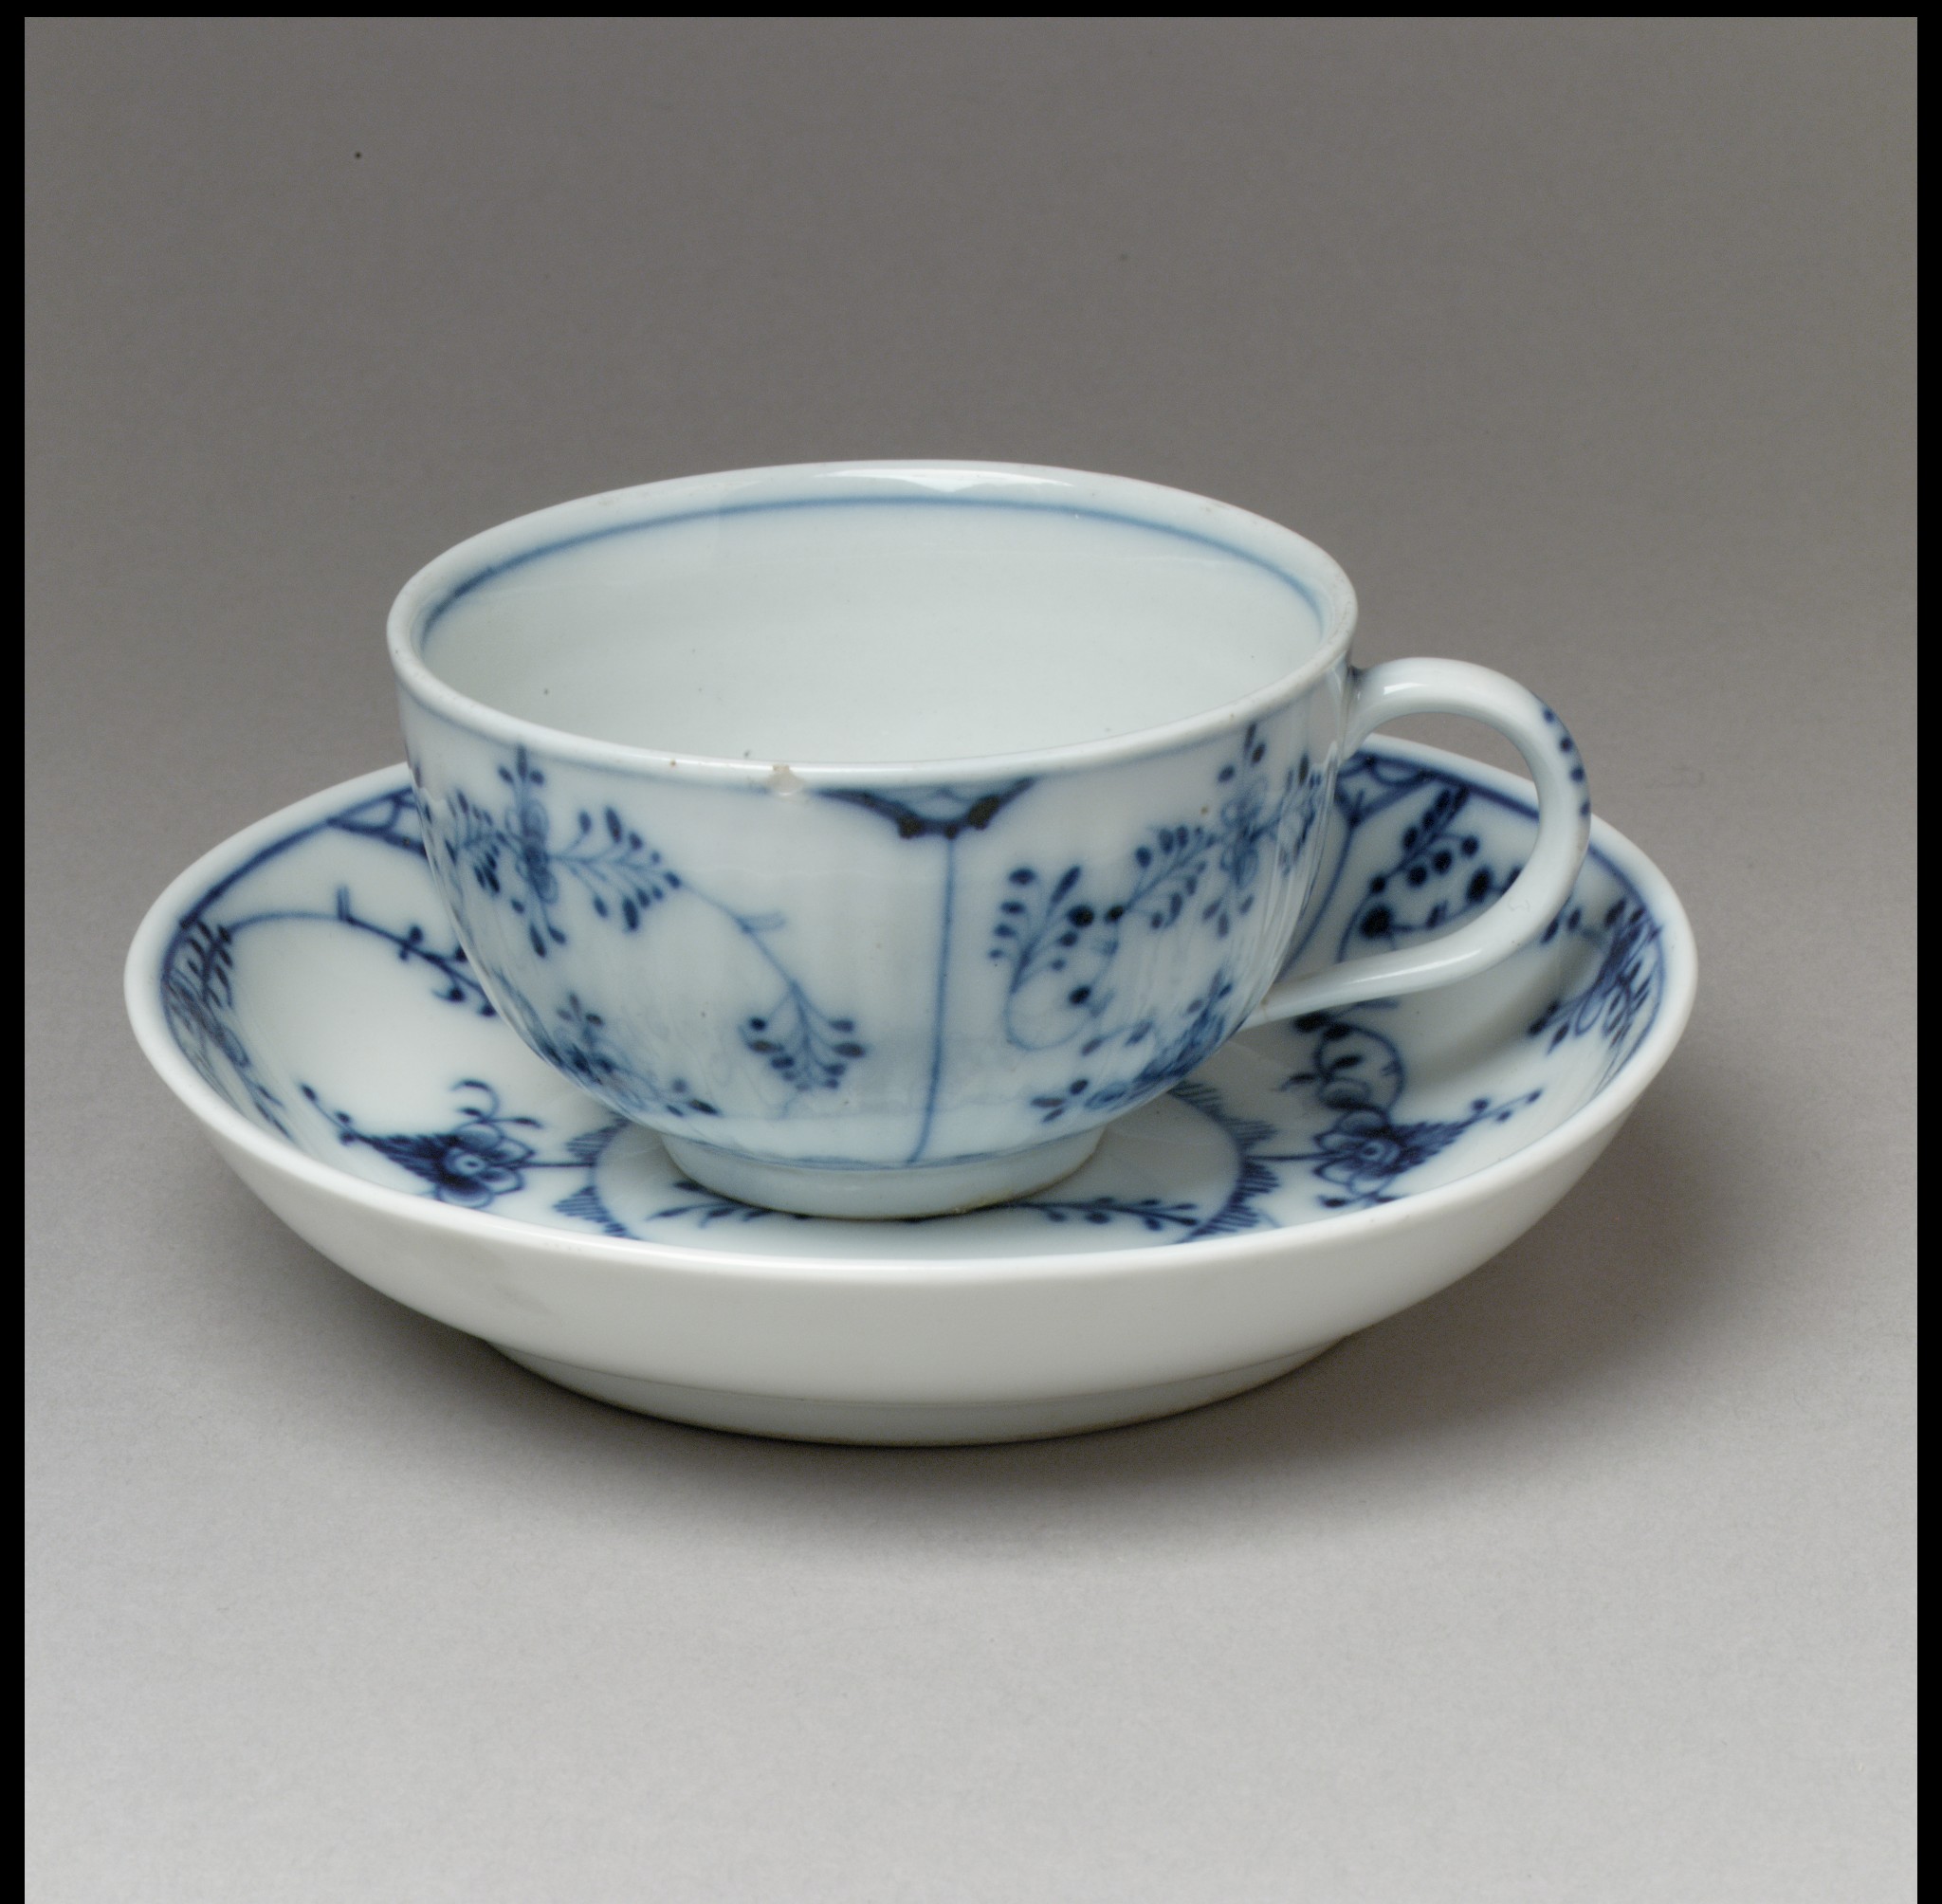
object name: cup and saucer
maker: royal porcelain manufactory, berlin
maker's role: manufactory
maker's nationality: german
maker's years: 1763-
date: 1780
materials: hard paste porcelain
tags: flowers